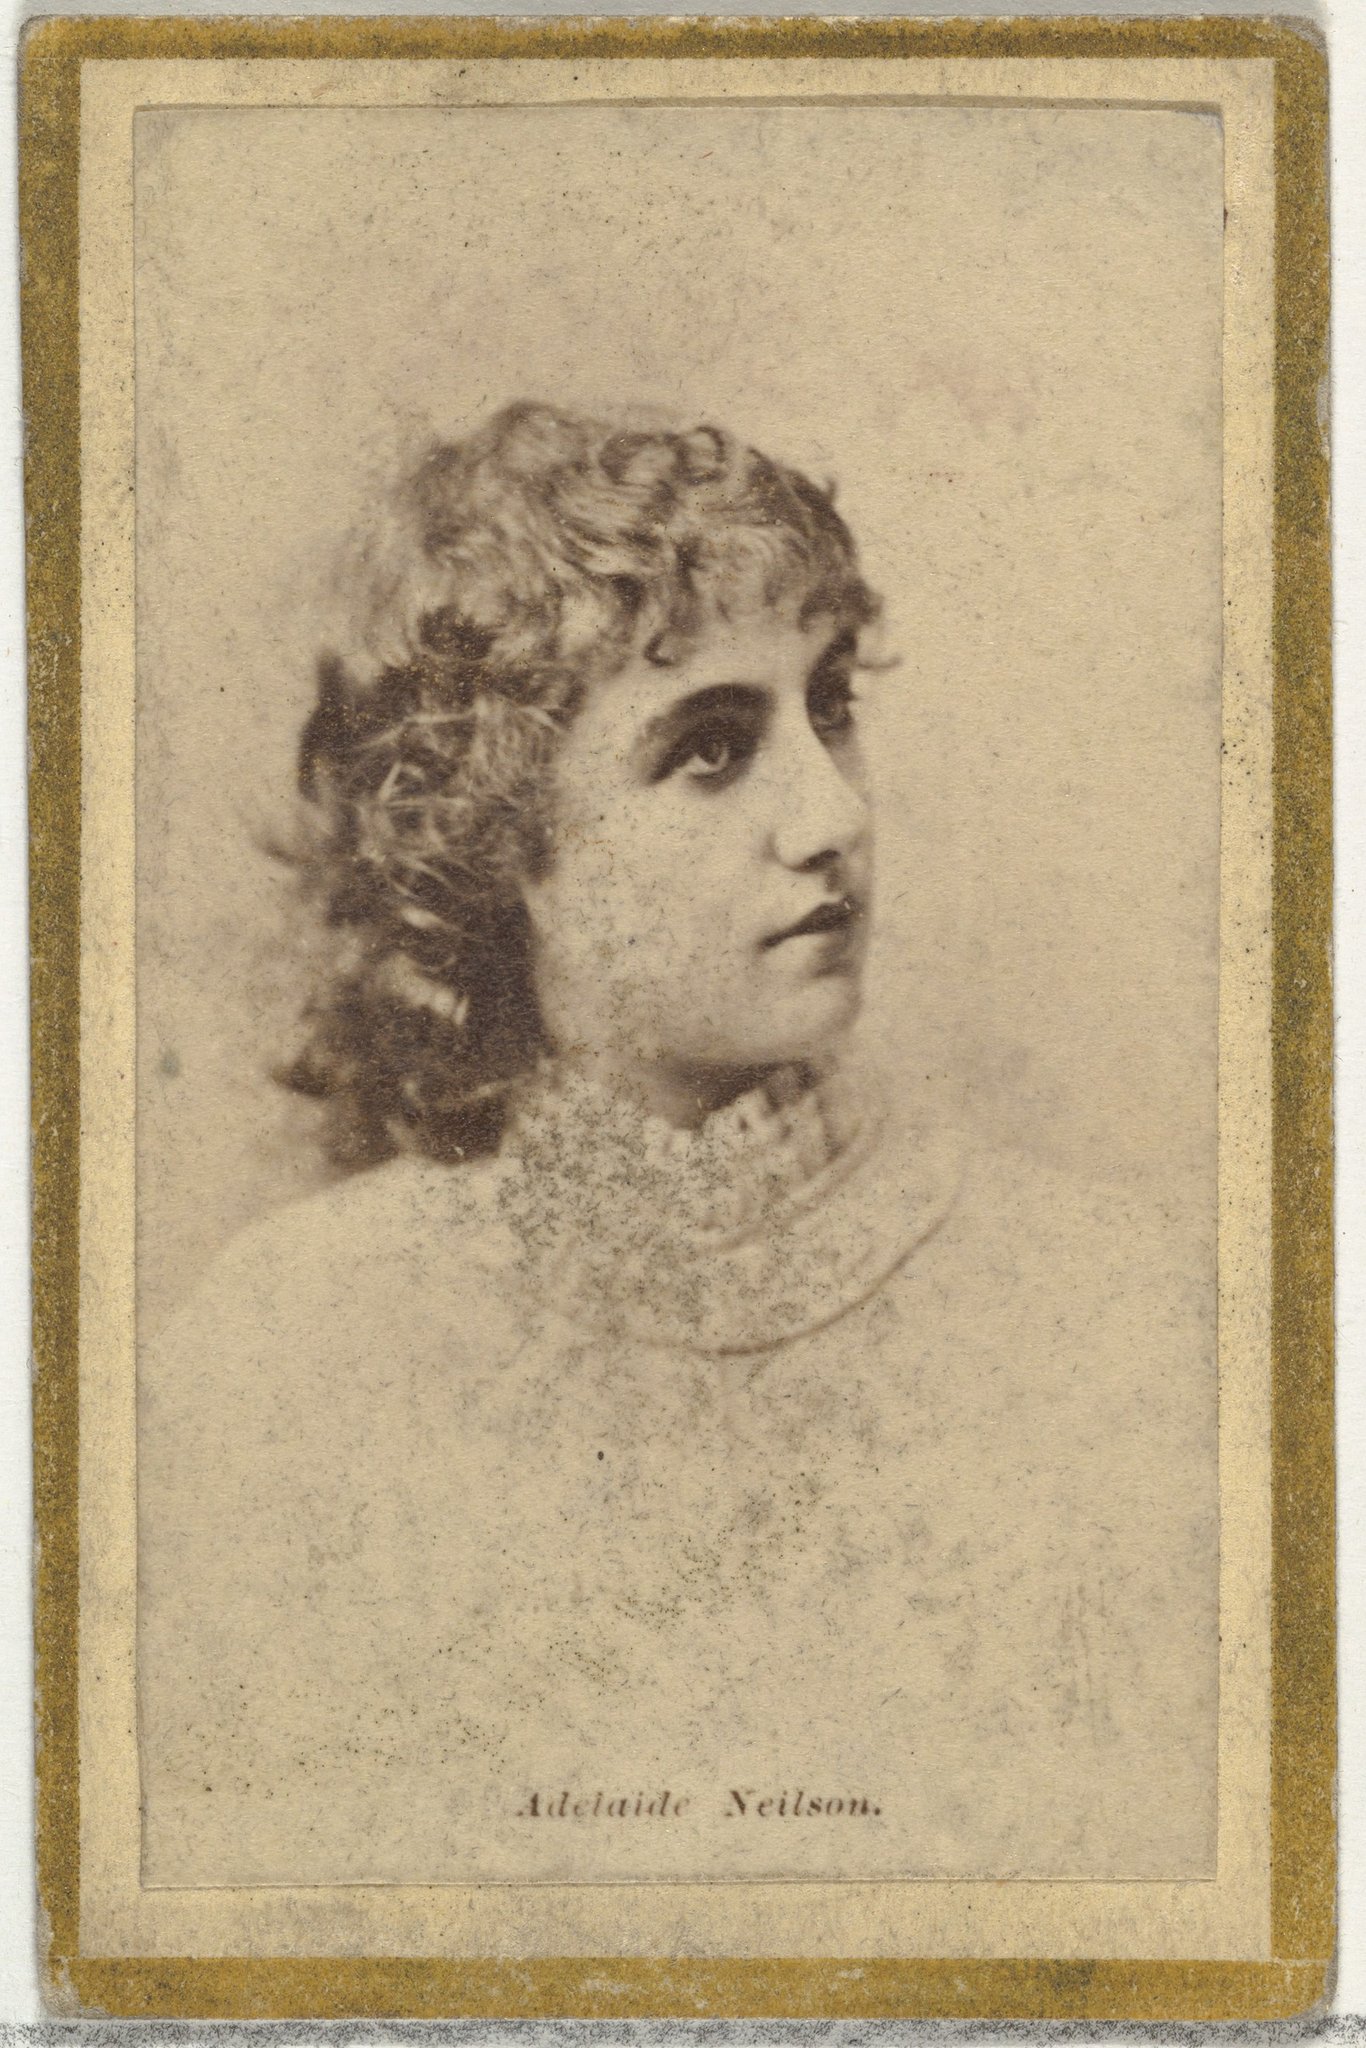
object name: photograph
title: Adelaide Neilson, from the Actresses and Celebrities series (N60, Type 2) promoting Little Beauties Cigarettes for Allen & Ginter brand tobacco products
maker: allen & ginter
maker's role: publisher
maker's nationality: american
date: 1887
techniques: albumen silver print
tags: portraits,women,actresses